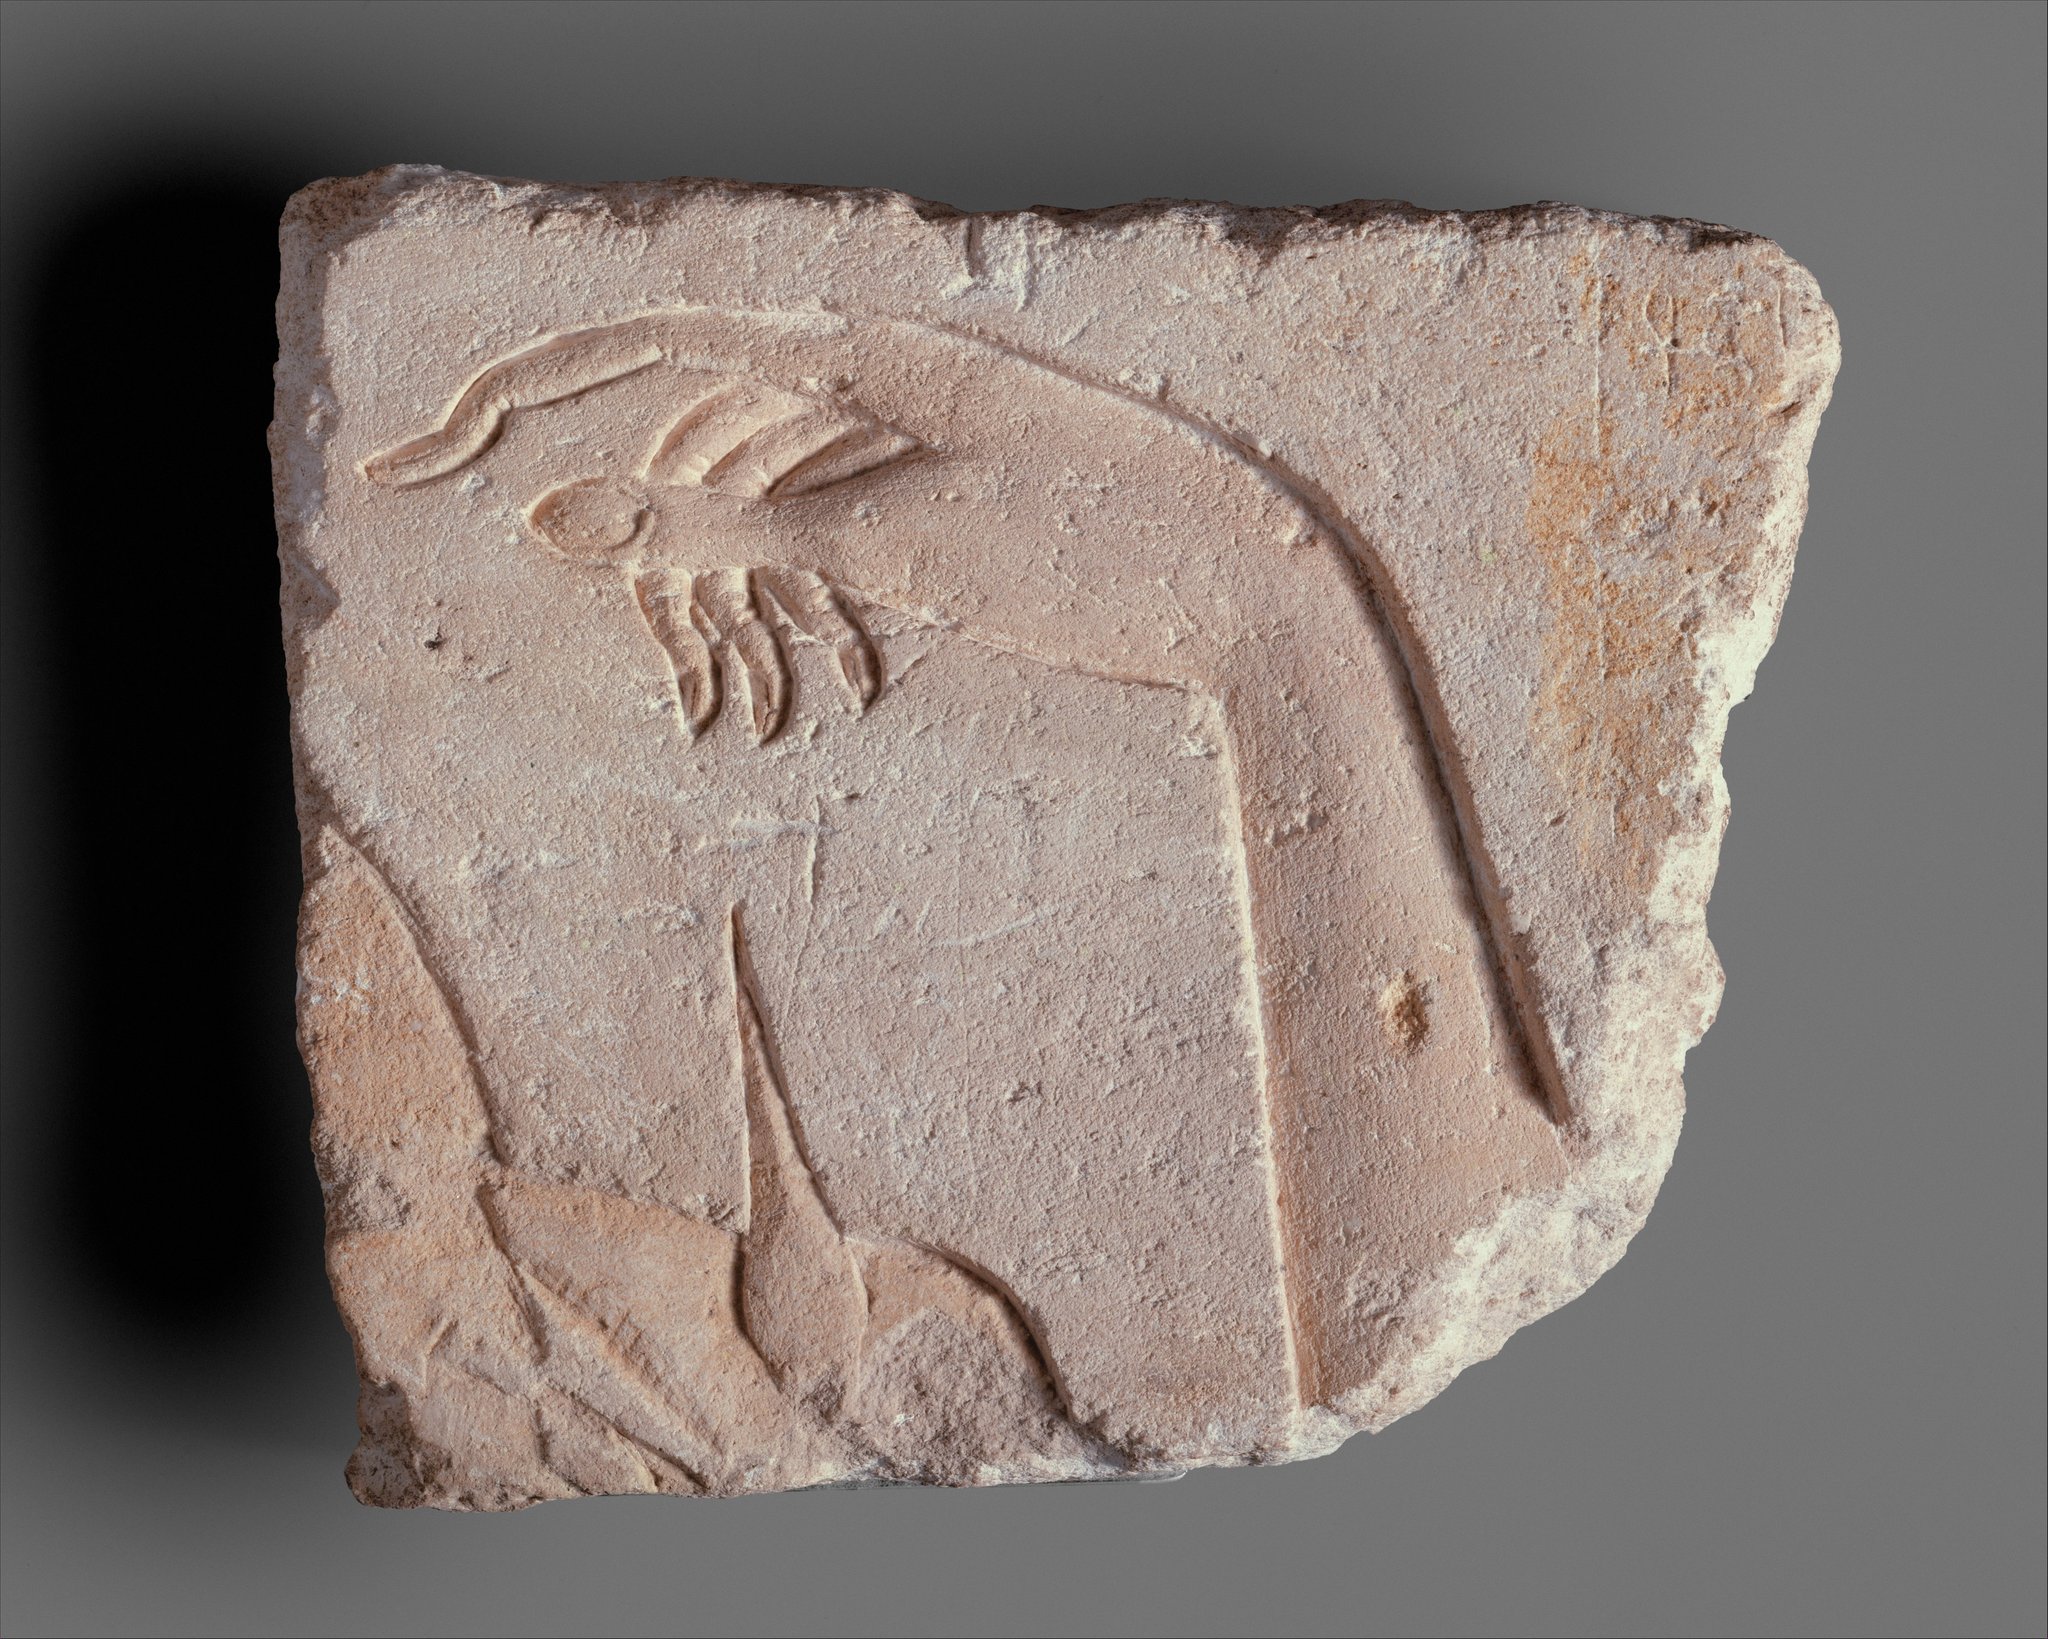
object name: talatat, royal hand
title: Royal hand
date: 1353-1336 BCE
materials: limestone, paint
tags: hands